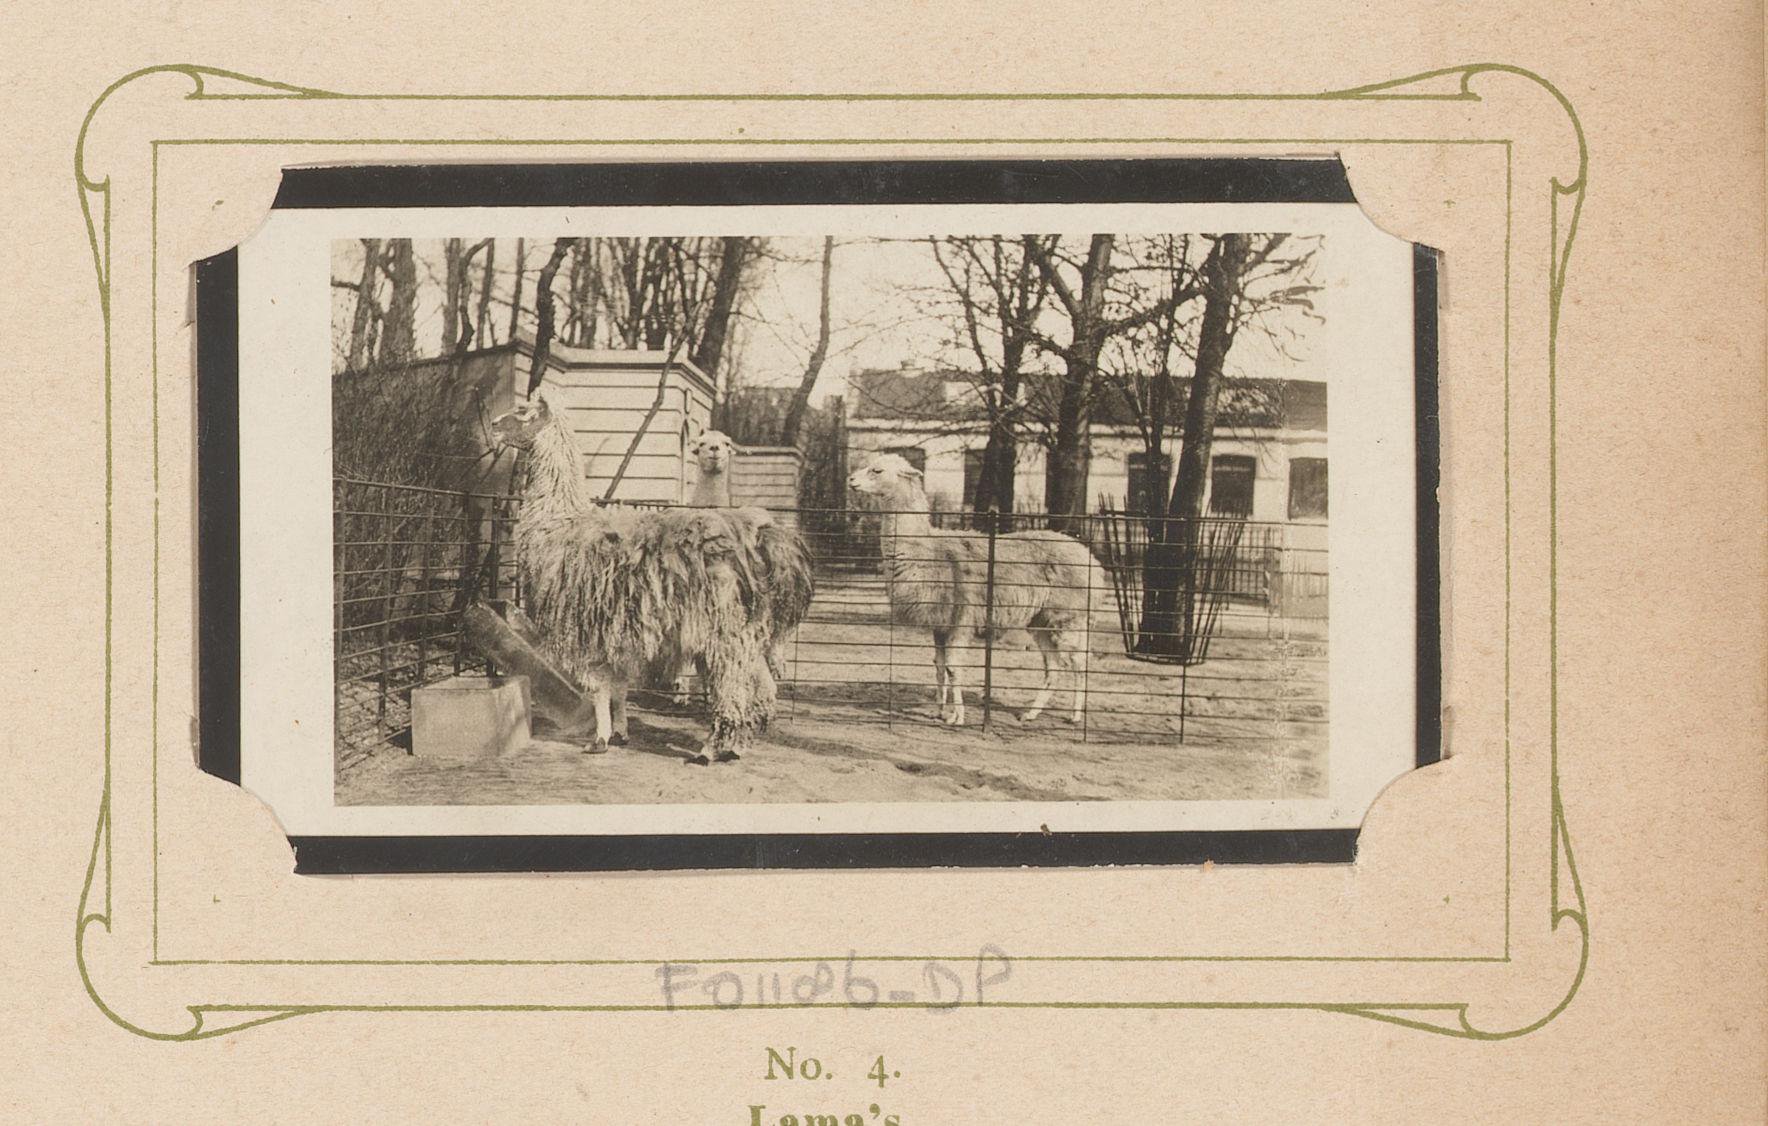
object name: album leaf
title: Lama's in Artis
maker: Anonymous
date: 1904-1905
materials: photographic support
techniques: gelatin silver print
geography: artis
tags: hoofed animals, zoo (as place of recreation)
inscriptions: inscription: ‘No. 4./ Lama's.’